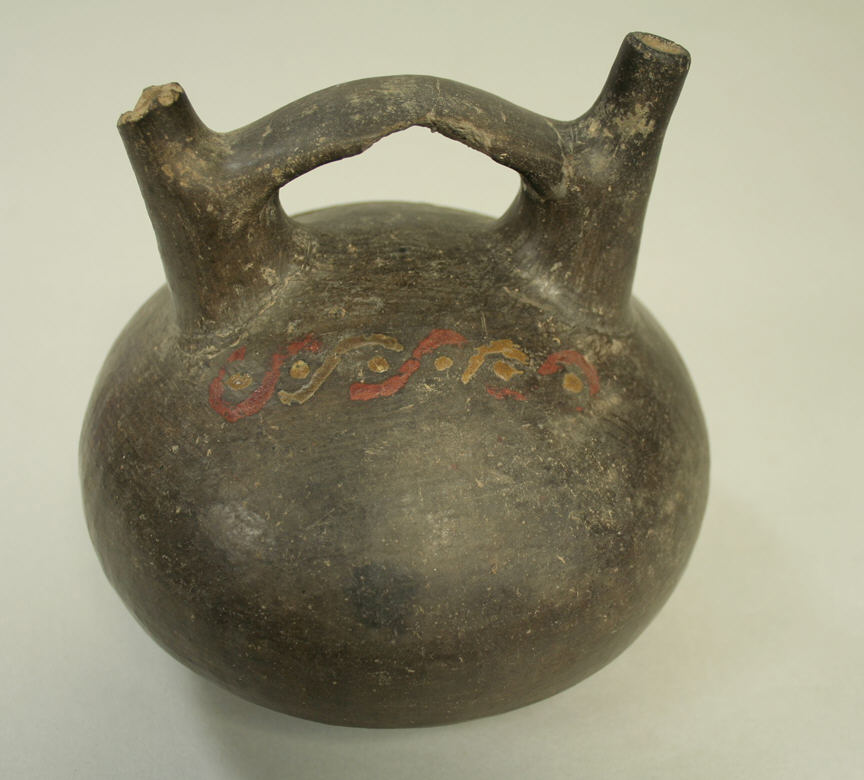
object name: bottle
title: Bridge and Double Spout Bottle with Guilloche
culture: paracas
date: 700-301 BCE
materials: ceramic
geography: peru